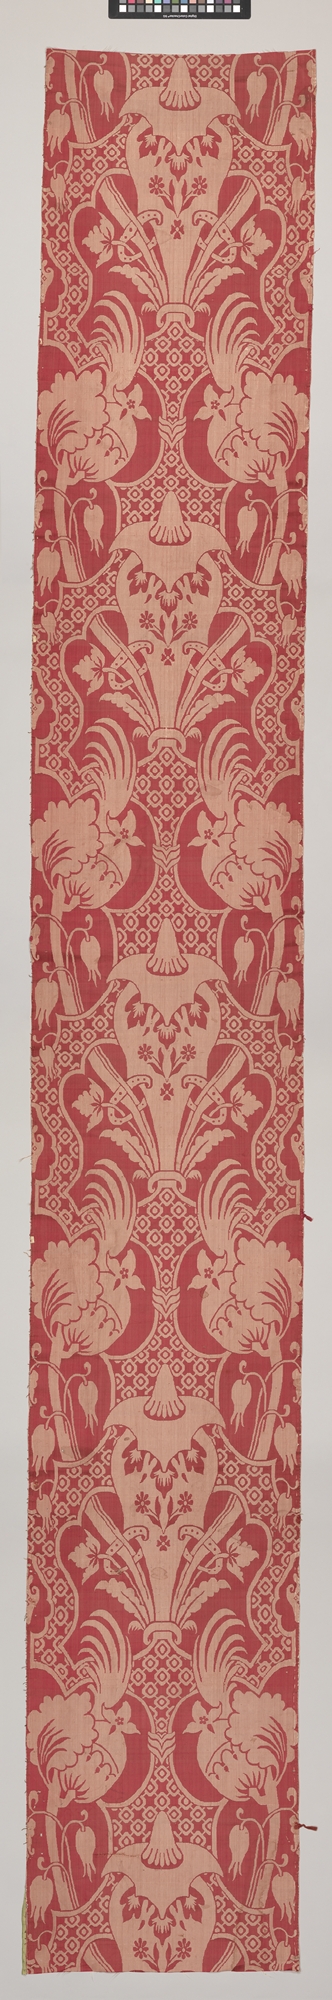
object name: furnishing textile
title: Furnishing damask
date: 1701-1733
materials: silk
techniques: damask